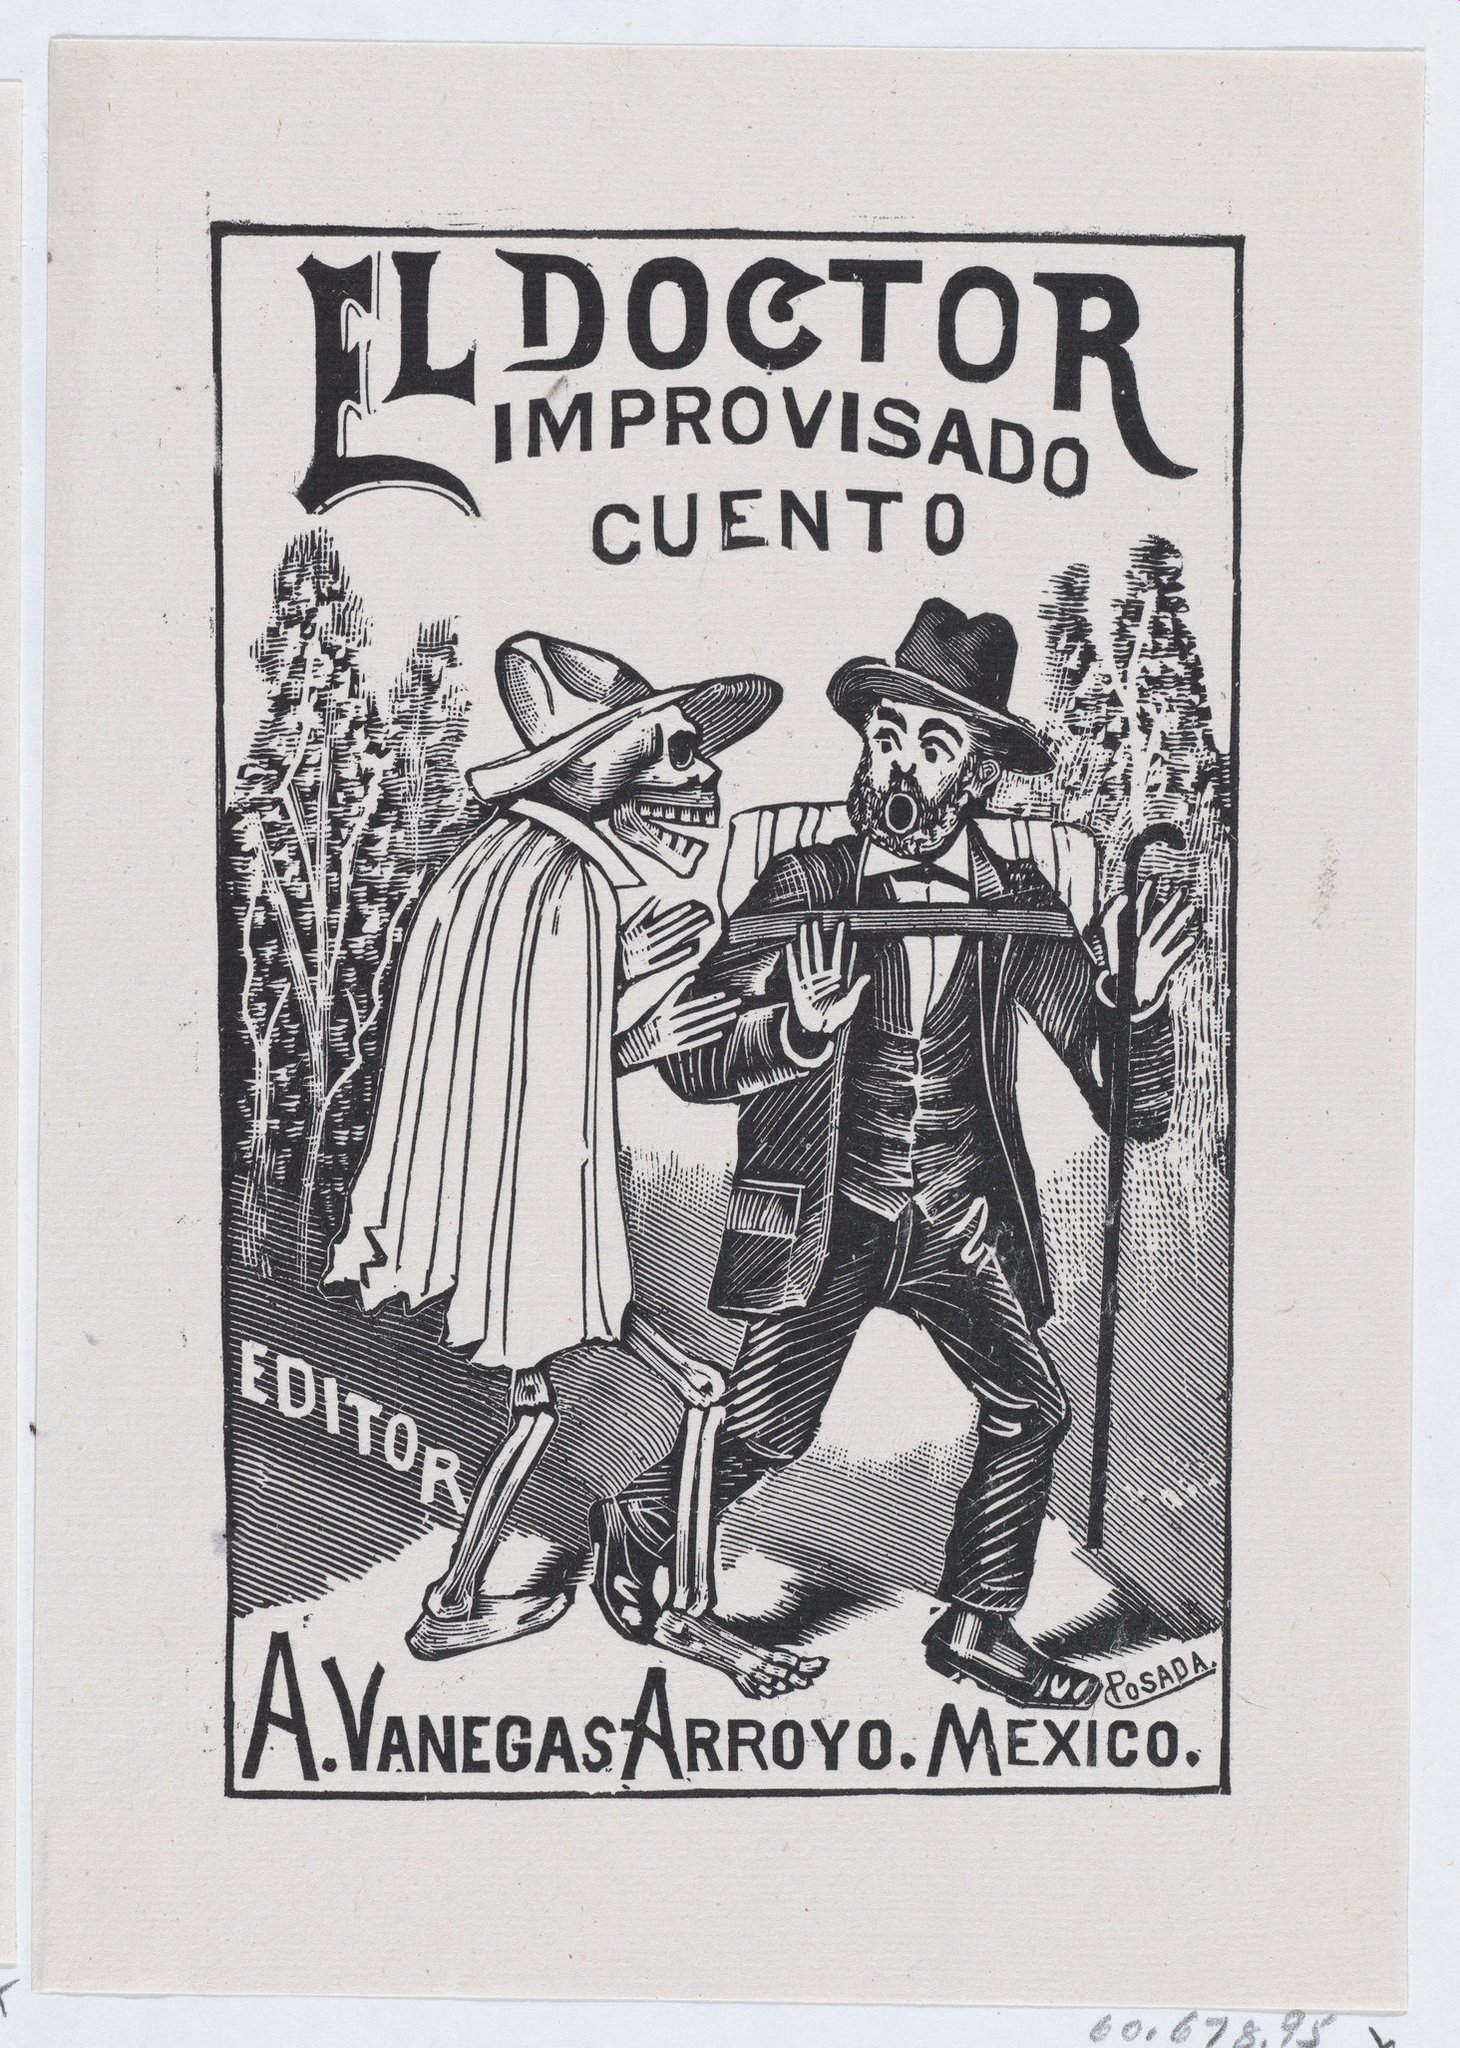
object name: print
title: A skeleton wearing a cape speaking to a frightened man with a cane and backpack, illustration for 'El Doctor Improvisado (The Impromptu Doctor)' edited by Antonio Vanegas Arroyo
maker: josé guadalupe posada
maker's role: artist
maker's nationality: mexican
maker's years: 1852-1913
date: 1894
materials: metal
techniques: engraving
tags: skeletons,fear,men